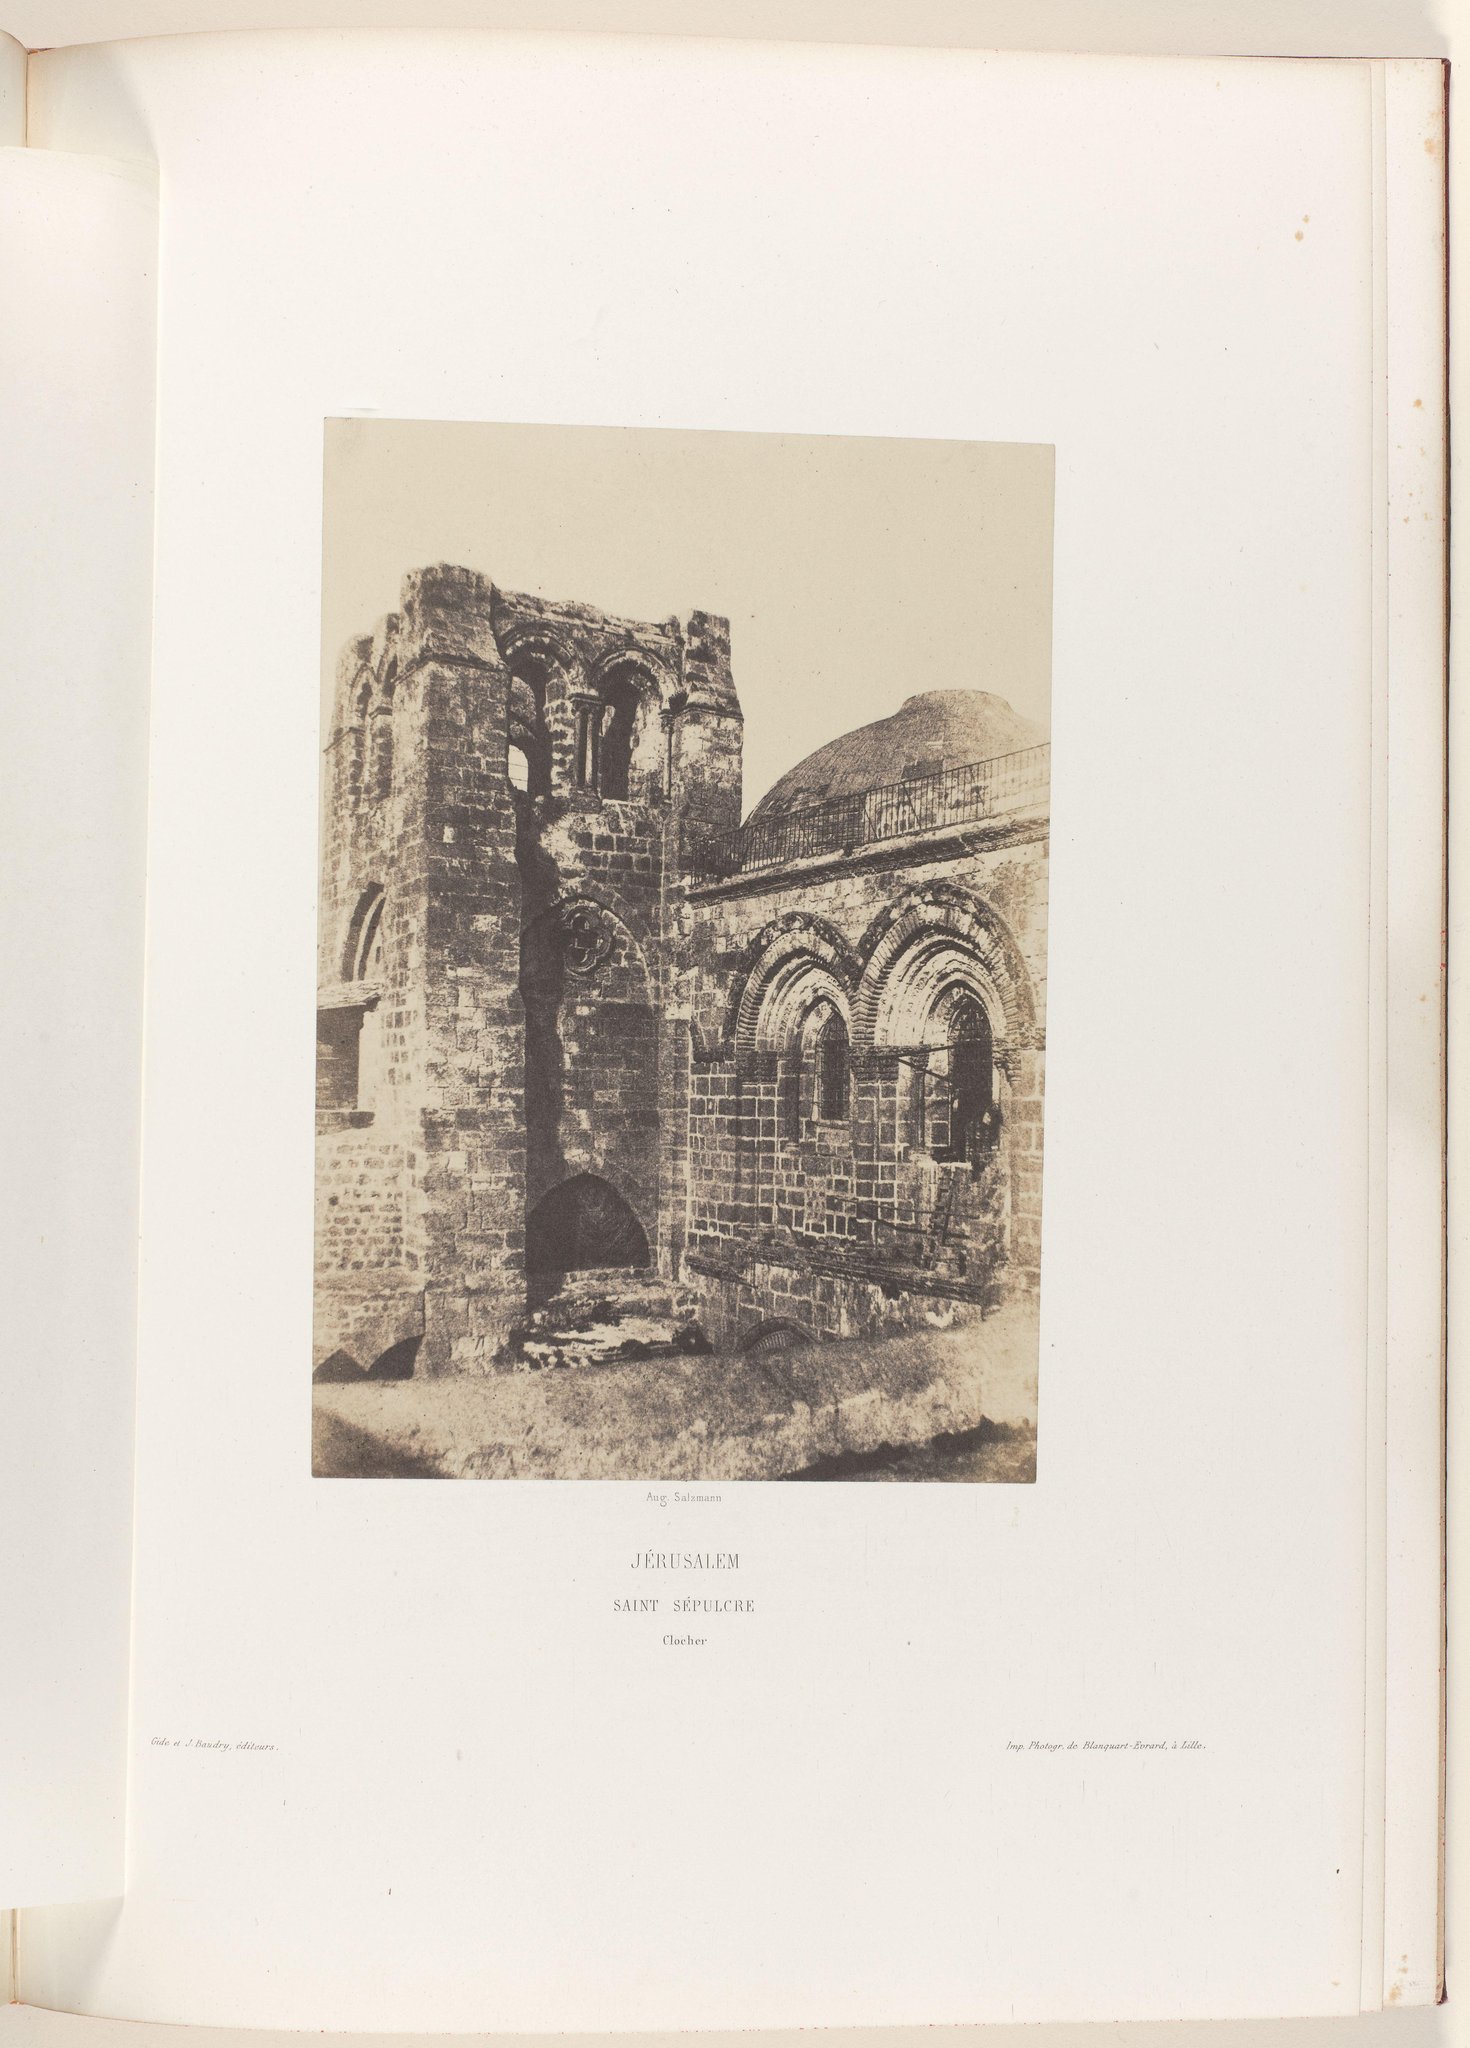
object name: page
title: Jérusalem. Saint Sépulcre. Clocher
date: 1854-1856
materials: cardboard, paper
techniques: salted paper print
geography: lille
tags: parts of church exterior and annexes: tower